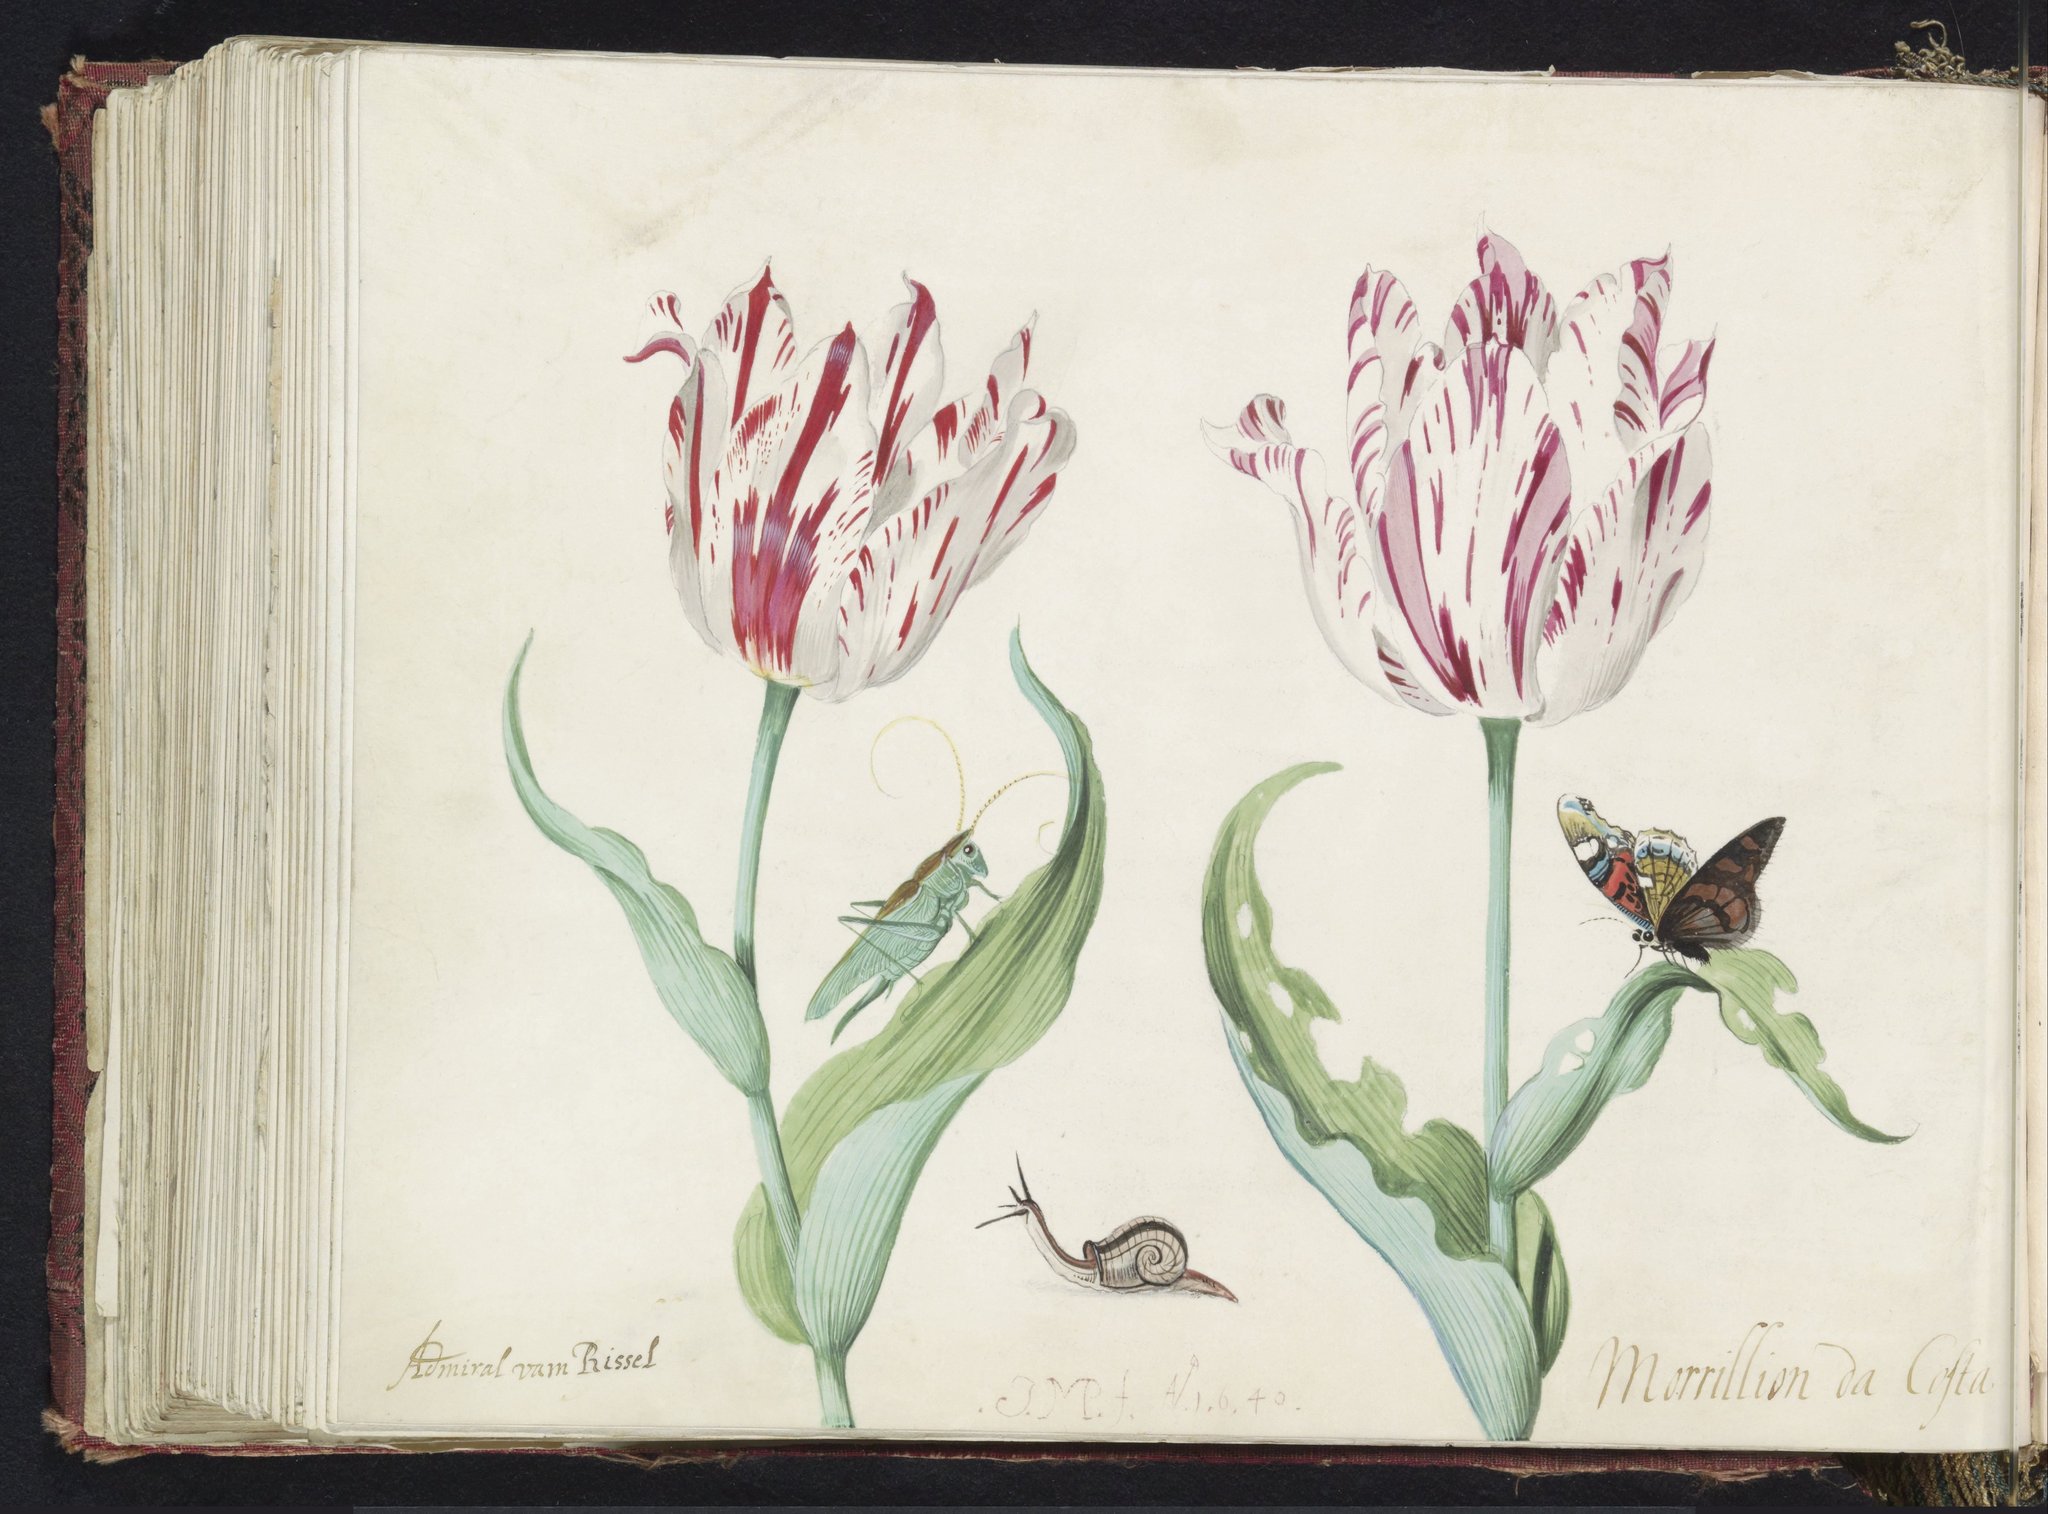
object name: album leaf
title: Admiral van Rissel / Morrillon da Costa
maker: jacob marrel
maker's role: draughtsman, painter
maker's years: 1614-1681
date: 1640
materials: paint, parchment, pencil, watercolor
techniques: brush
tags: insects: butterfly, flowers: tulip, molluscs: snail, insects: grass-hopper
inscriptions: date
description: De tekening maakt deel uit van een album.